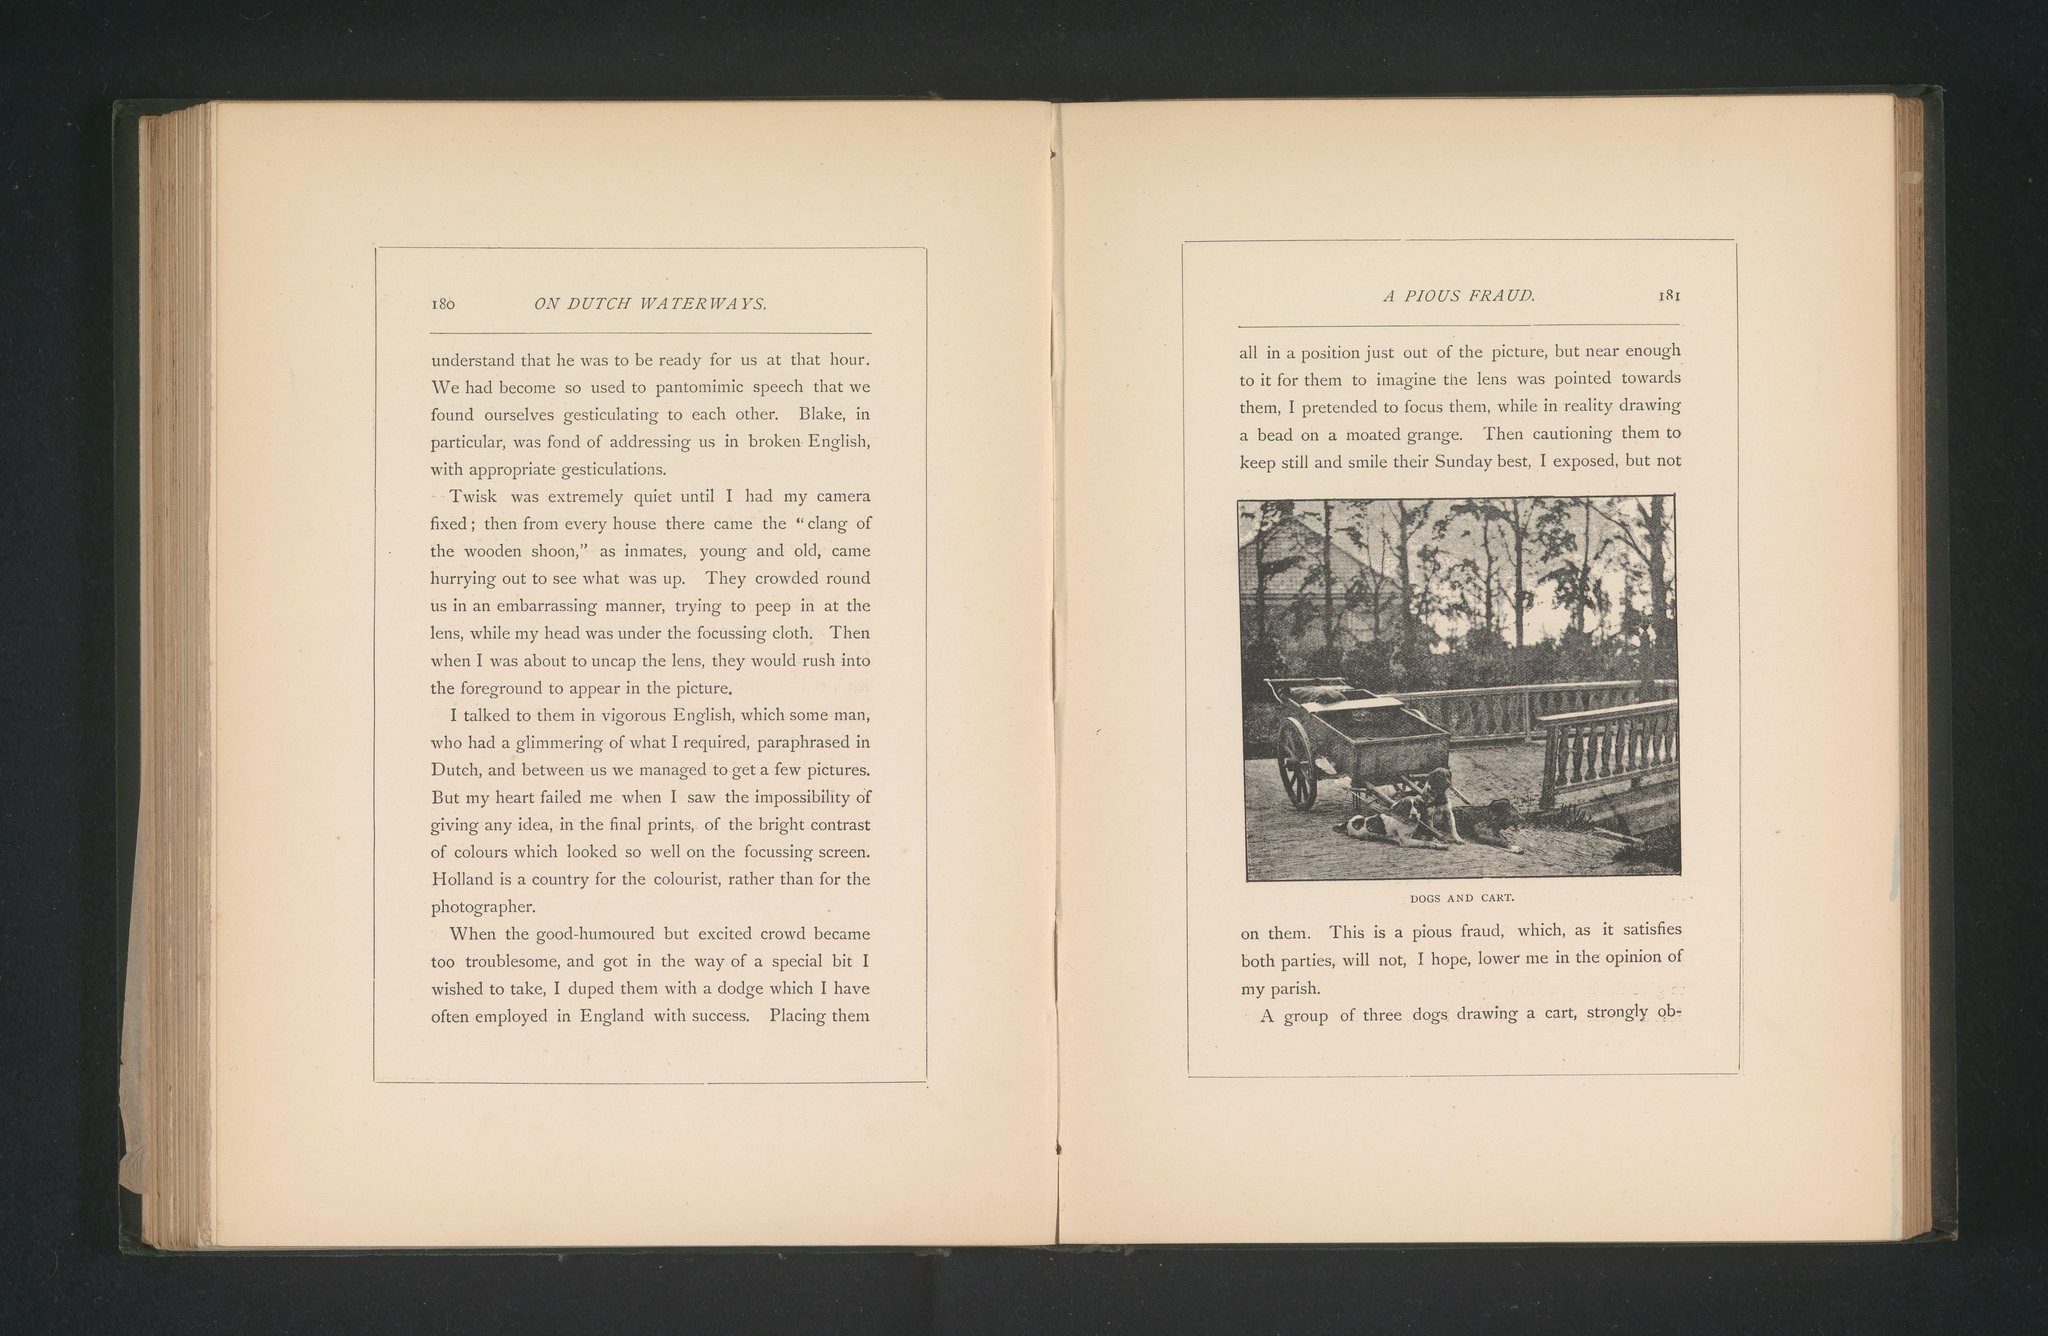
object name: page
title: Dogs and Cart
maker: george christopher davies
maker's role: fotograaf, geoloog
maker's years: 1849-1922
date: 1881-1886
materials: paper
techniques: autotype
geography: london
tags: two-wheeled vehicle drawn by three animals, dog, netherlands